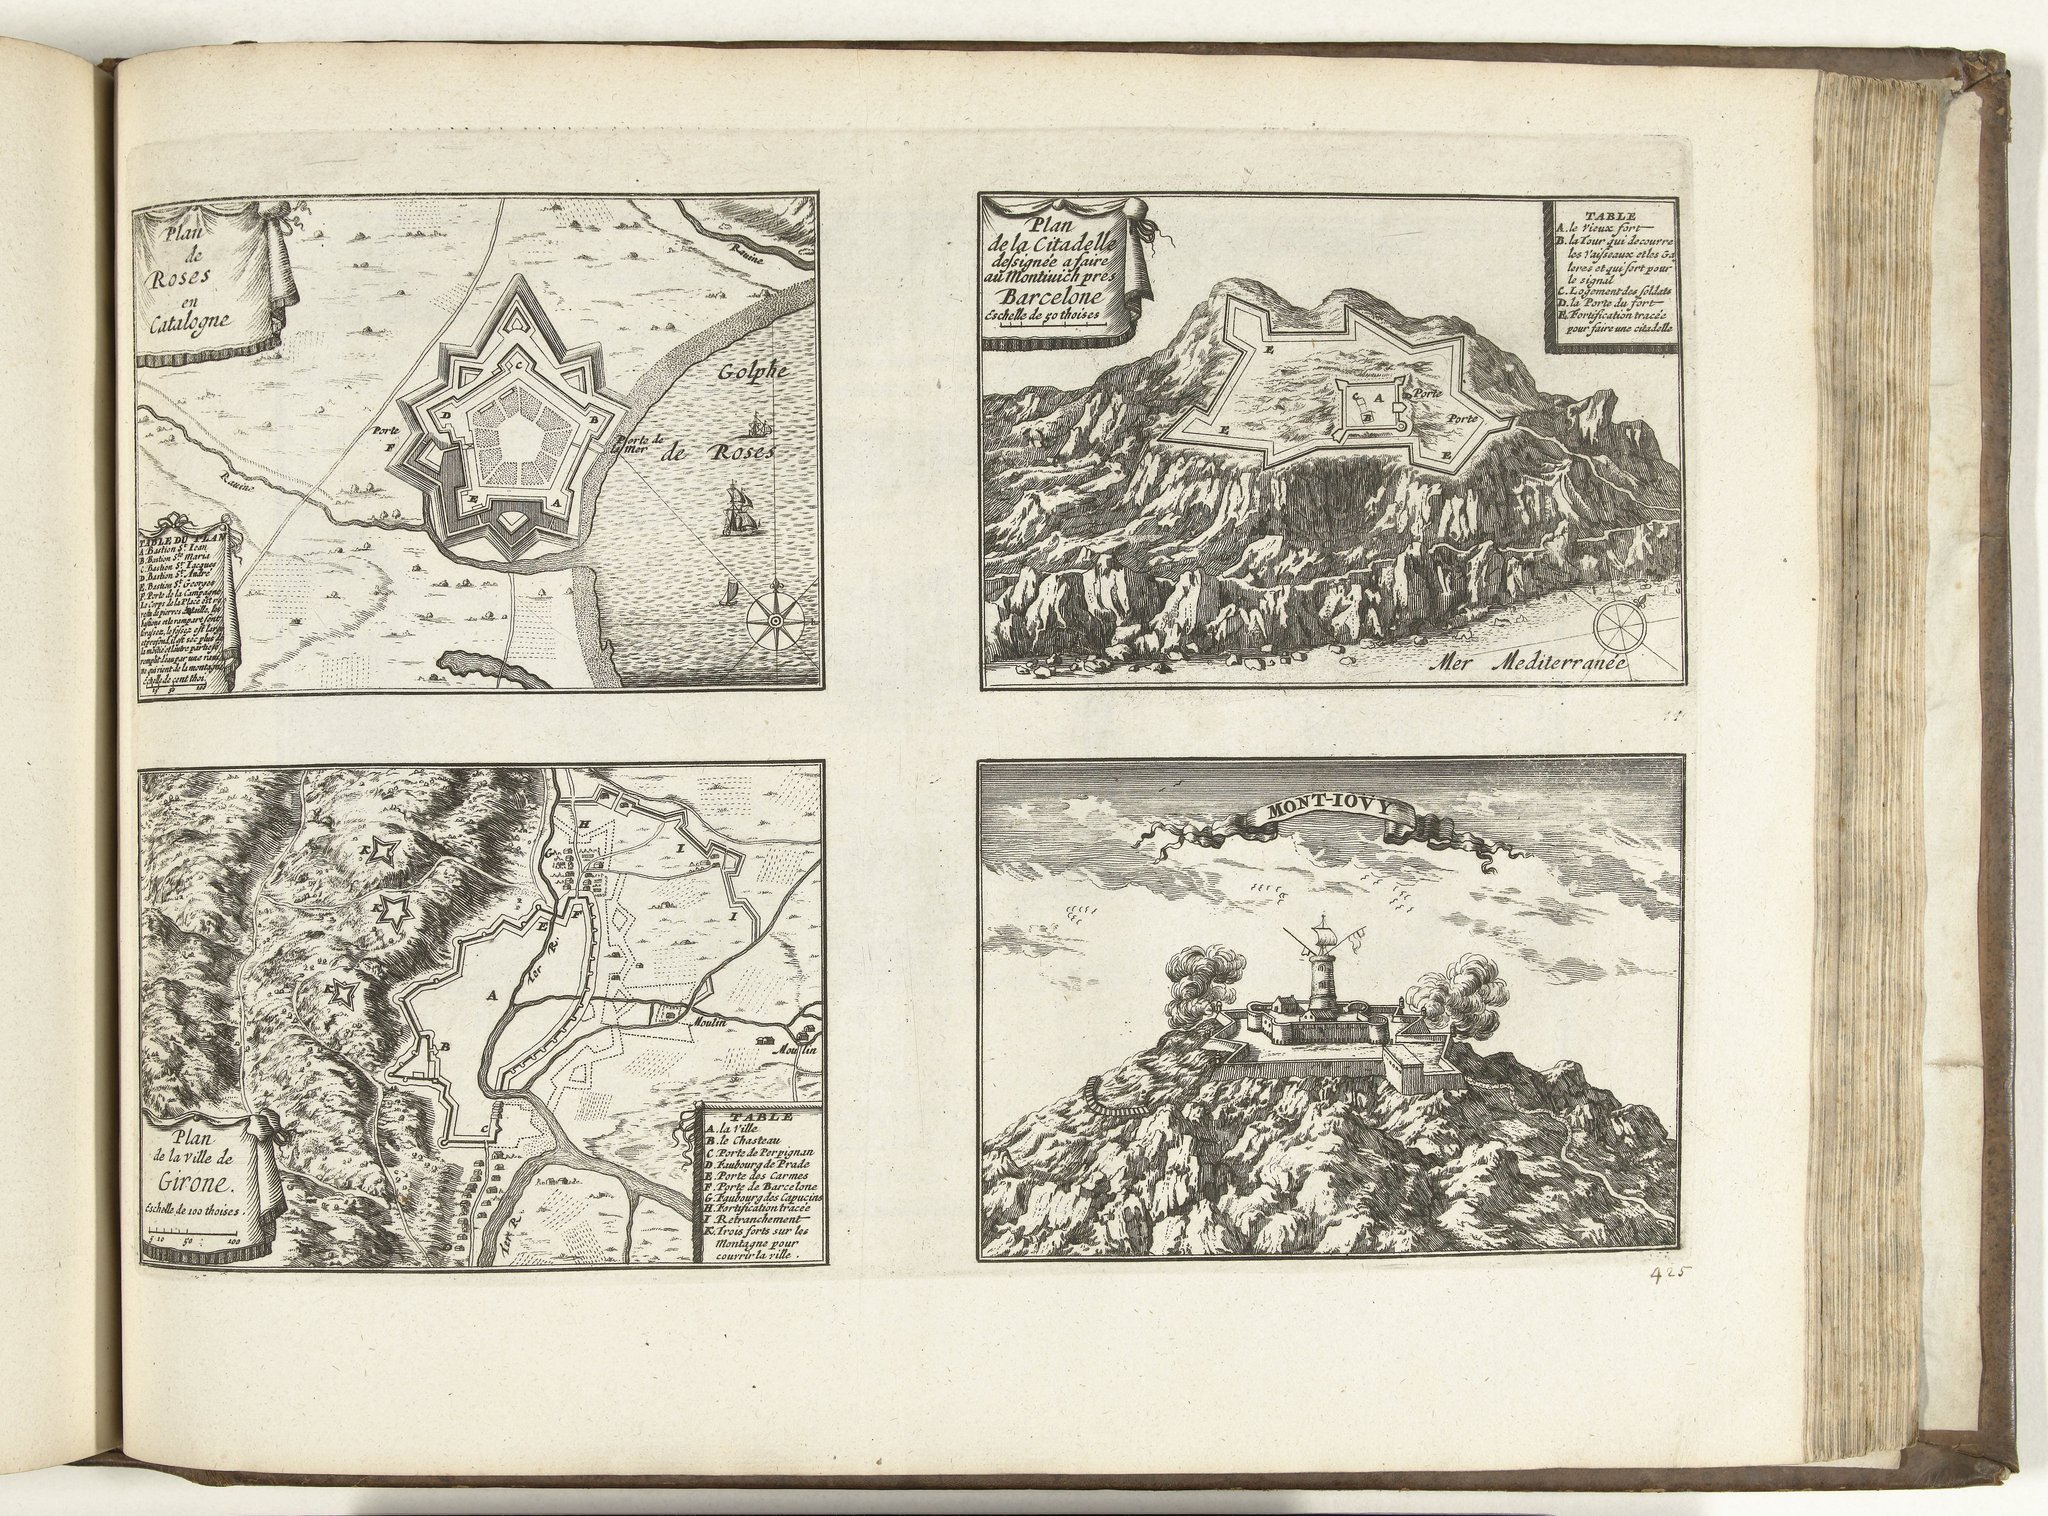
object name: map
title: Les Forces de l'Europe, Asie, Afrique et Amerique (...) Comme aussi les Cartes des Côtes de France et d'Espagne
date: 1726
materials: paper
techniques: etching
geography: northern netherlands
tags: fortress, maps of cities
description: Blad met vier plattegronden van de versterkingen om Rosas, Gerona en andere plaatsen in Catalonië. Plaat nr. 425 in deel XVII van het prentwerk: Les Forces de l'Europe, Asie, Afrique et Amerique ... Comme aussi les Cartes des Côtes de France et d'Espagne uit 1726, dit tweede deel met 271 met de hand genummerde platen van vermaarde sterke steden en vestingen in het kader van de Spaanse Successieoorlog 1701-1713. Voor het merendeel zijn deze platen gekopieerd naar de anonieme Franse platen van vermaarde sterke steden en vestingen: in Les forces de l'Europe en in: Le theatre de la guerre, dans les Pays-Bas, beide oorspronkelijk uitgegeven door Nicolas de Fer te Parijs (1693-1697) in het kader van de Negenjarige Oorlog. Titels en opschriften in het Frans.